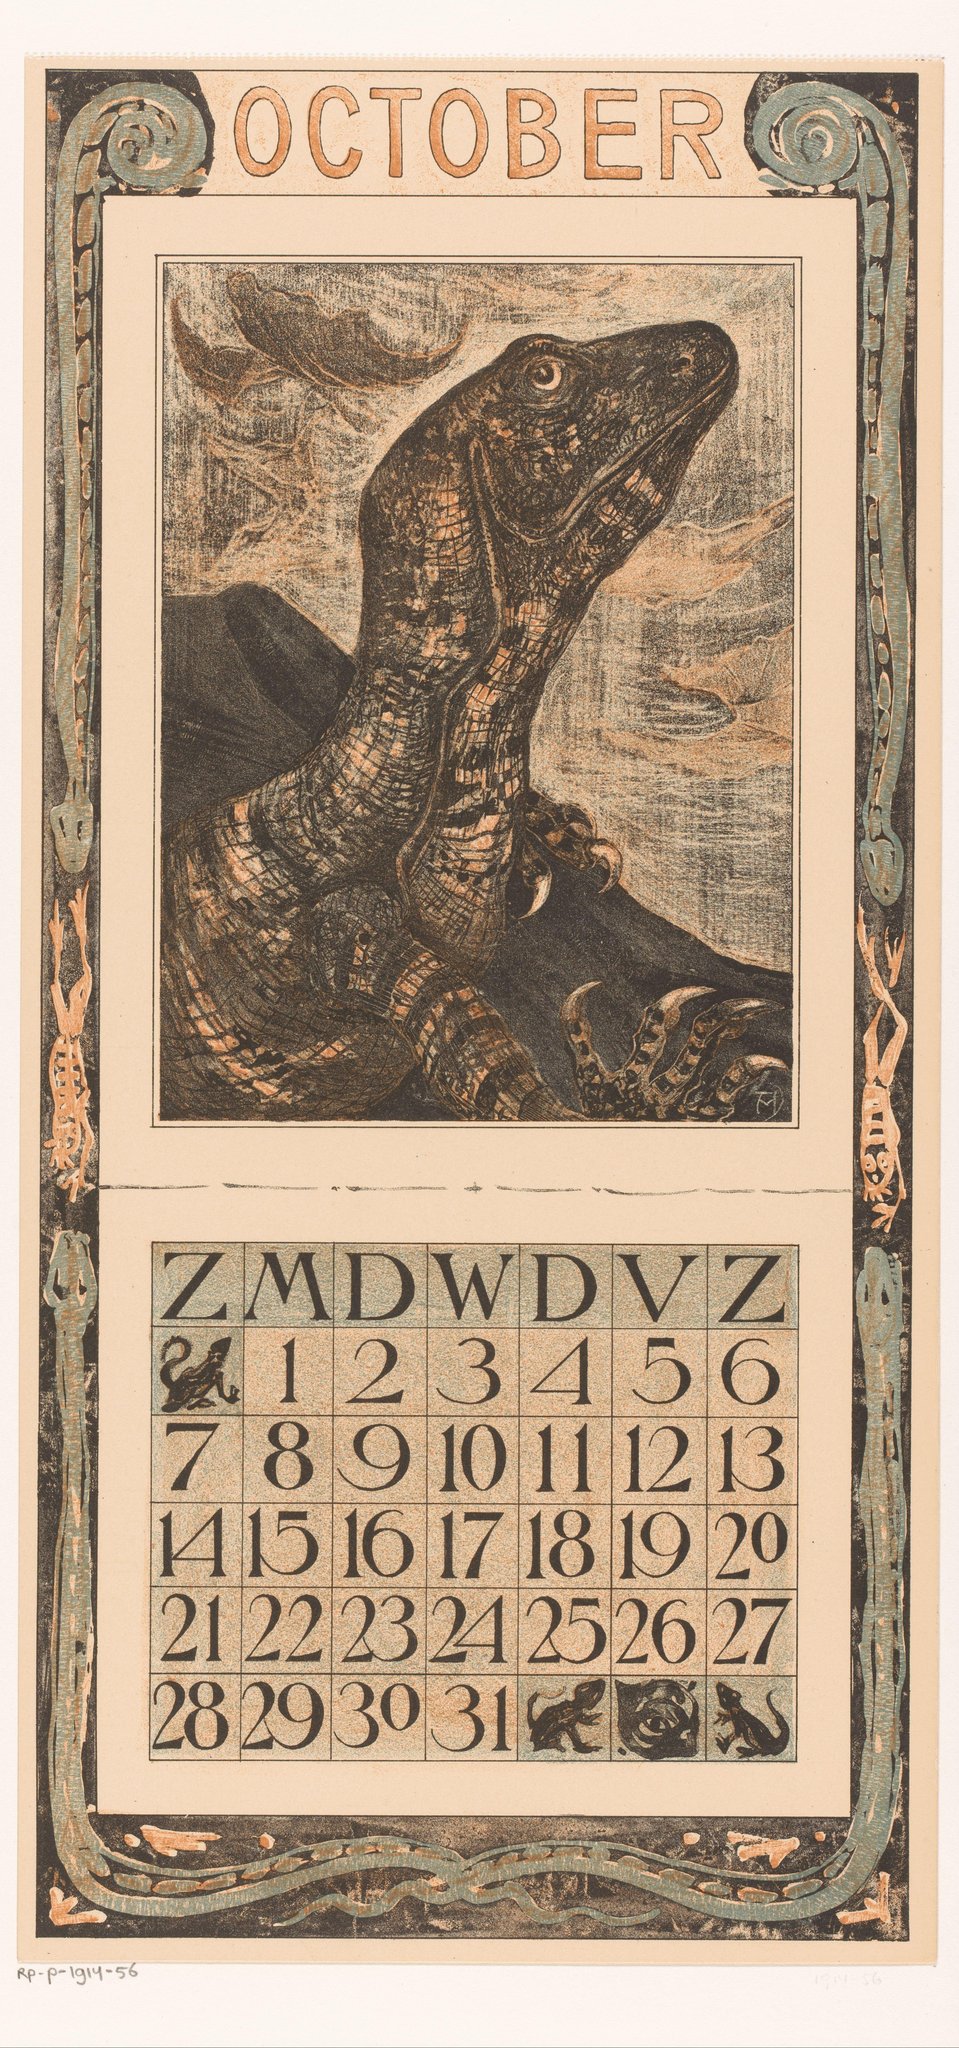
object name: print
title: Kalenderblad oktober met leguaan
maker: theo van hoytema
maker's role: draughtsman, painter, print maker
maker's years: 1863-1917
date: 1905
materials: paper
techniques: lithograph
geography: amsterdam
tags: reptiles, october ~ other concepts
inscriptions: collector's mark: Lugt 2228